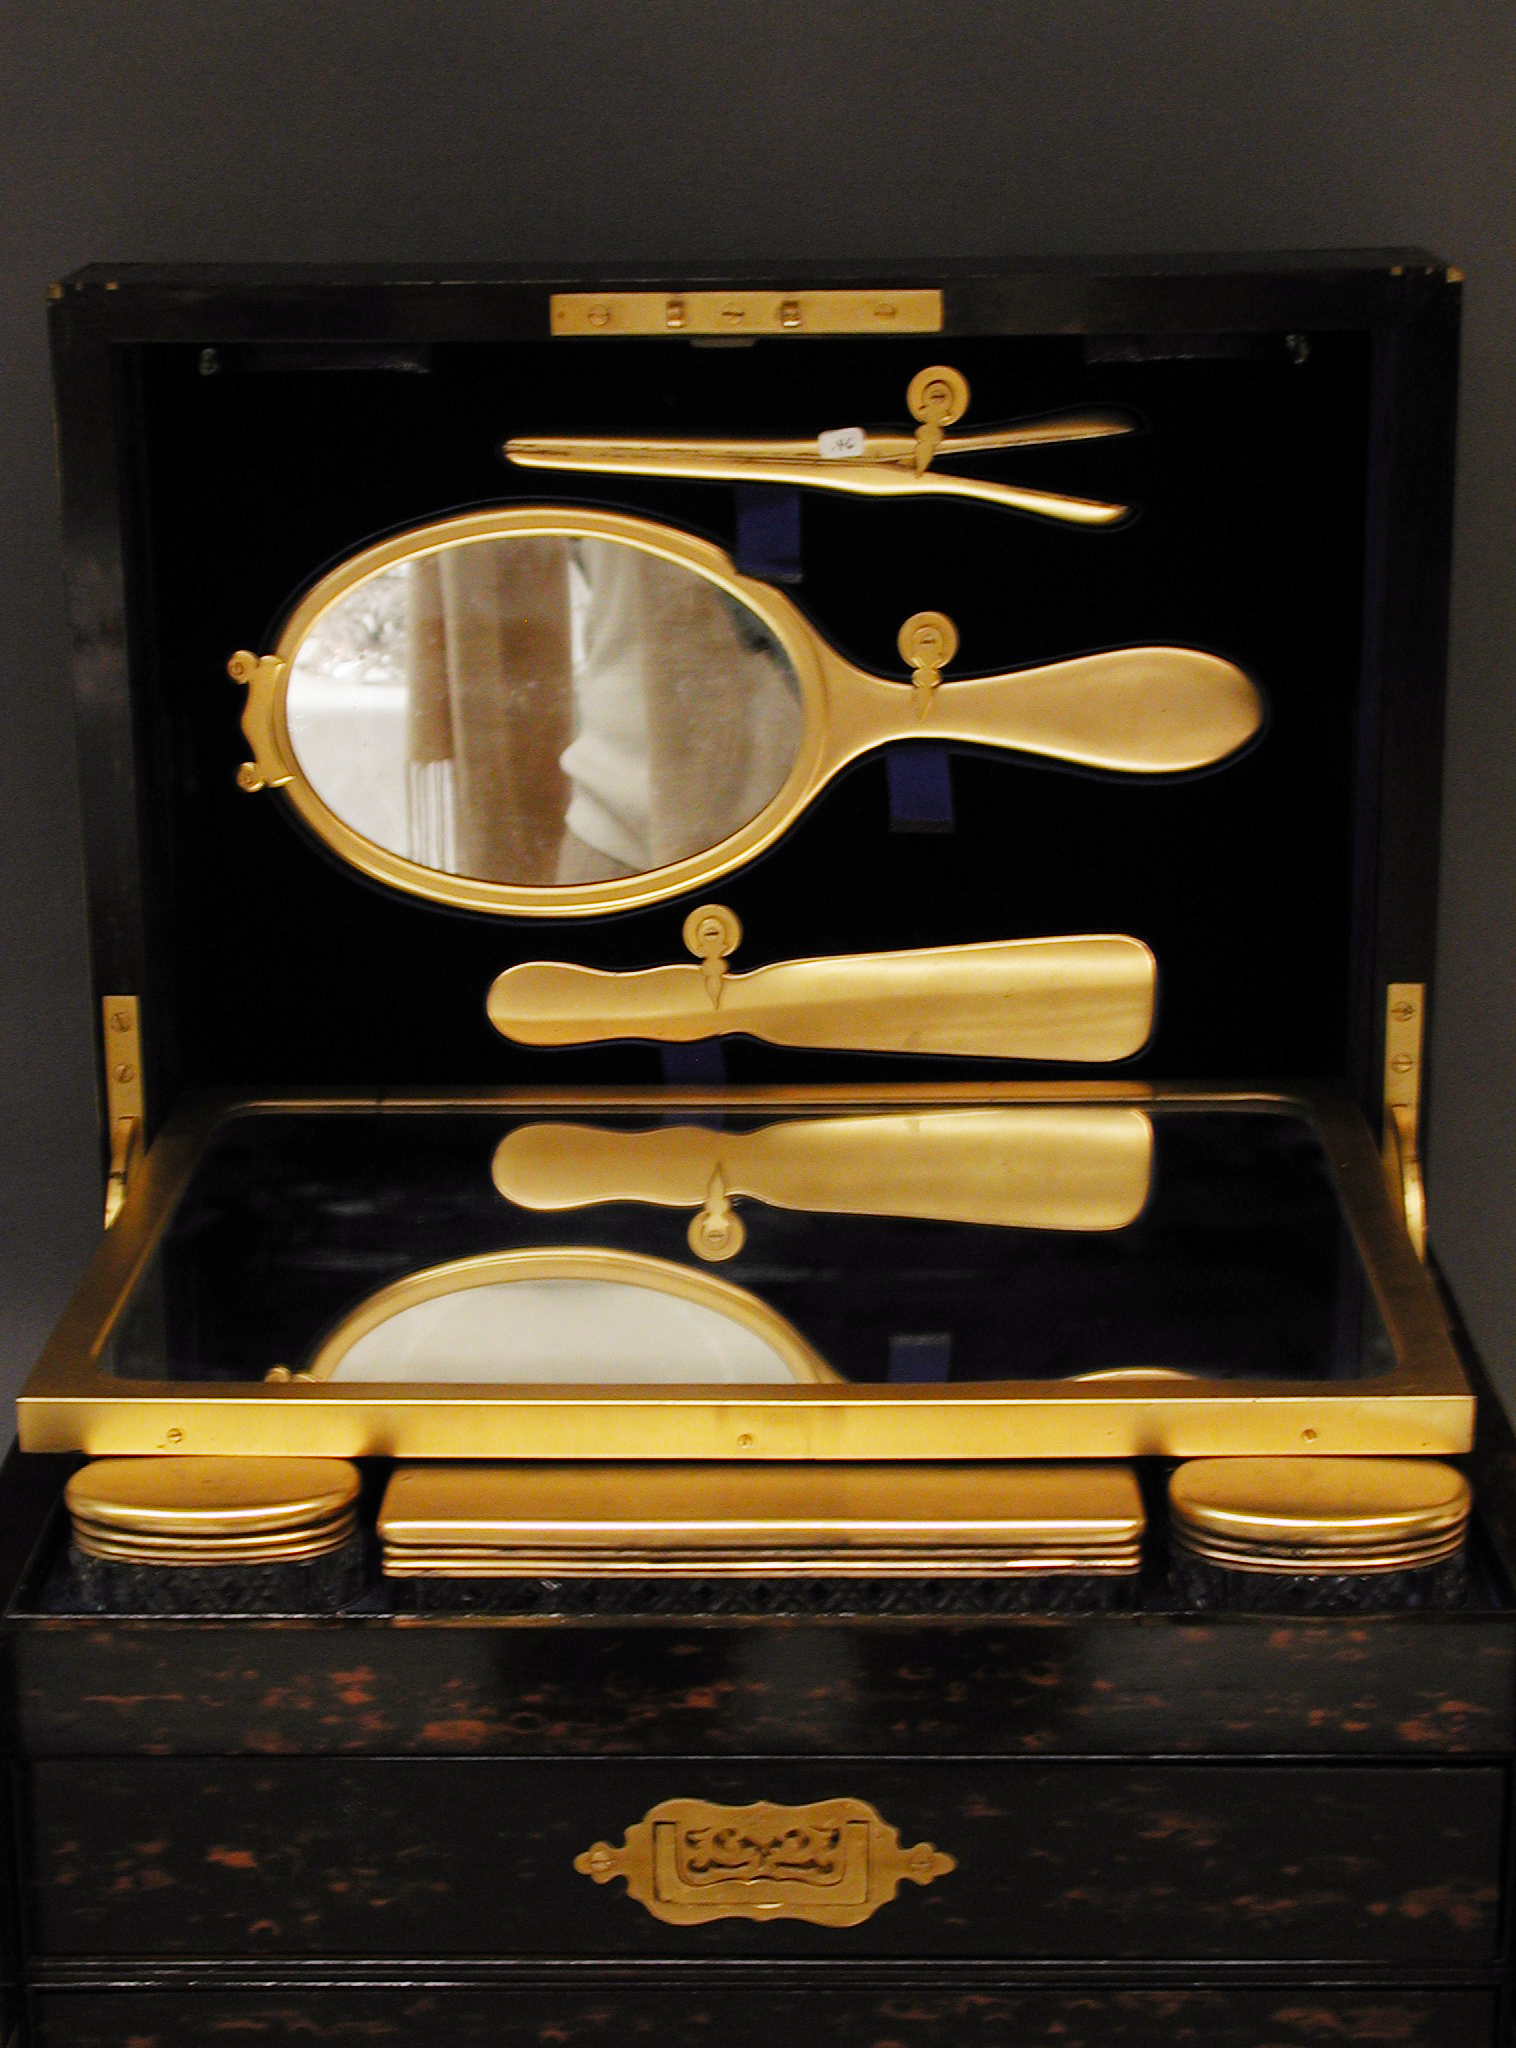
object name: glove stretcher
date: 1874-1875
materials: silver